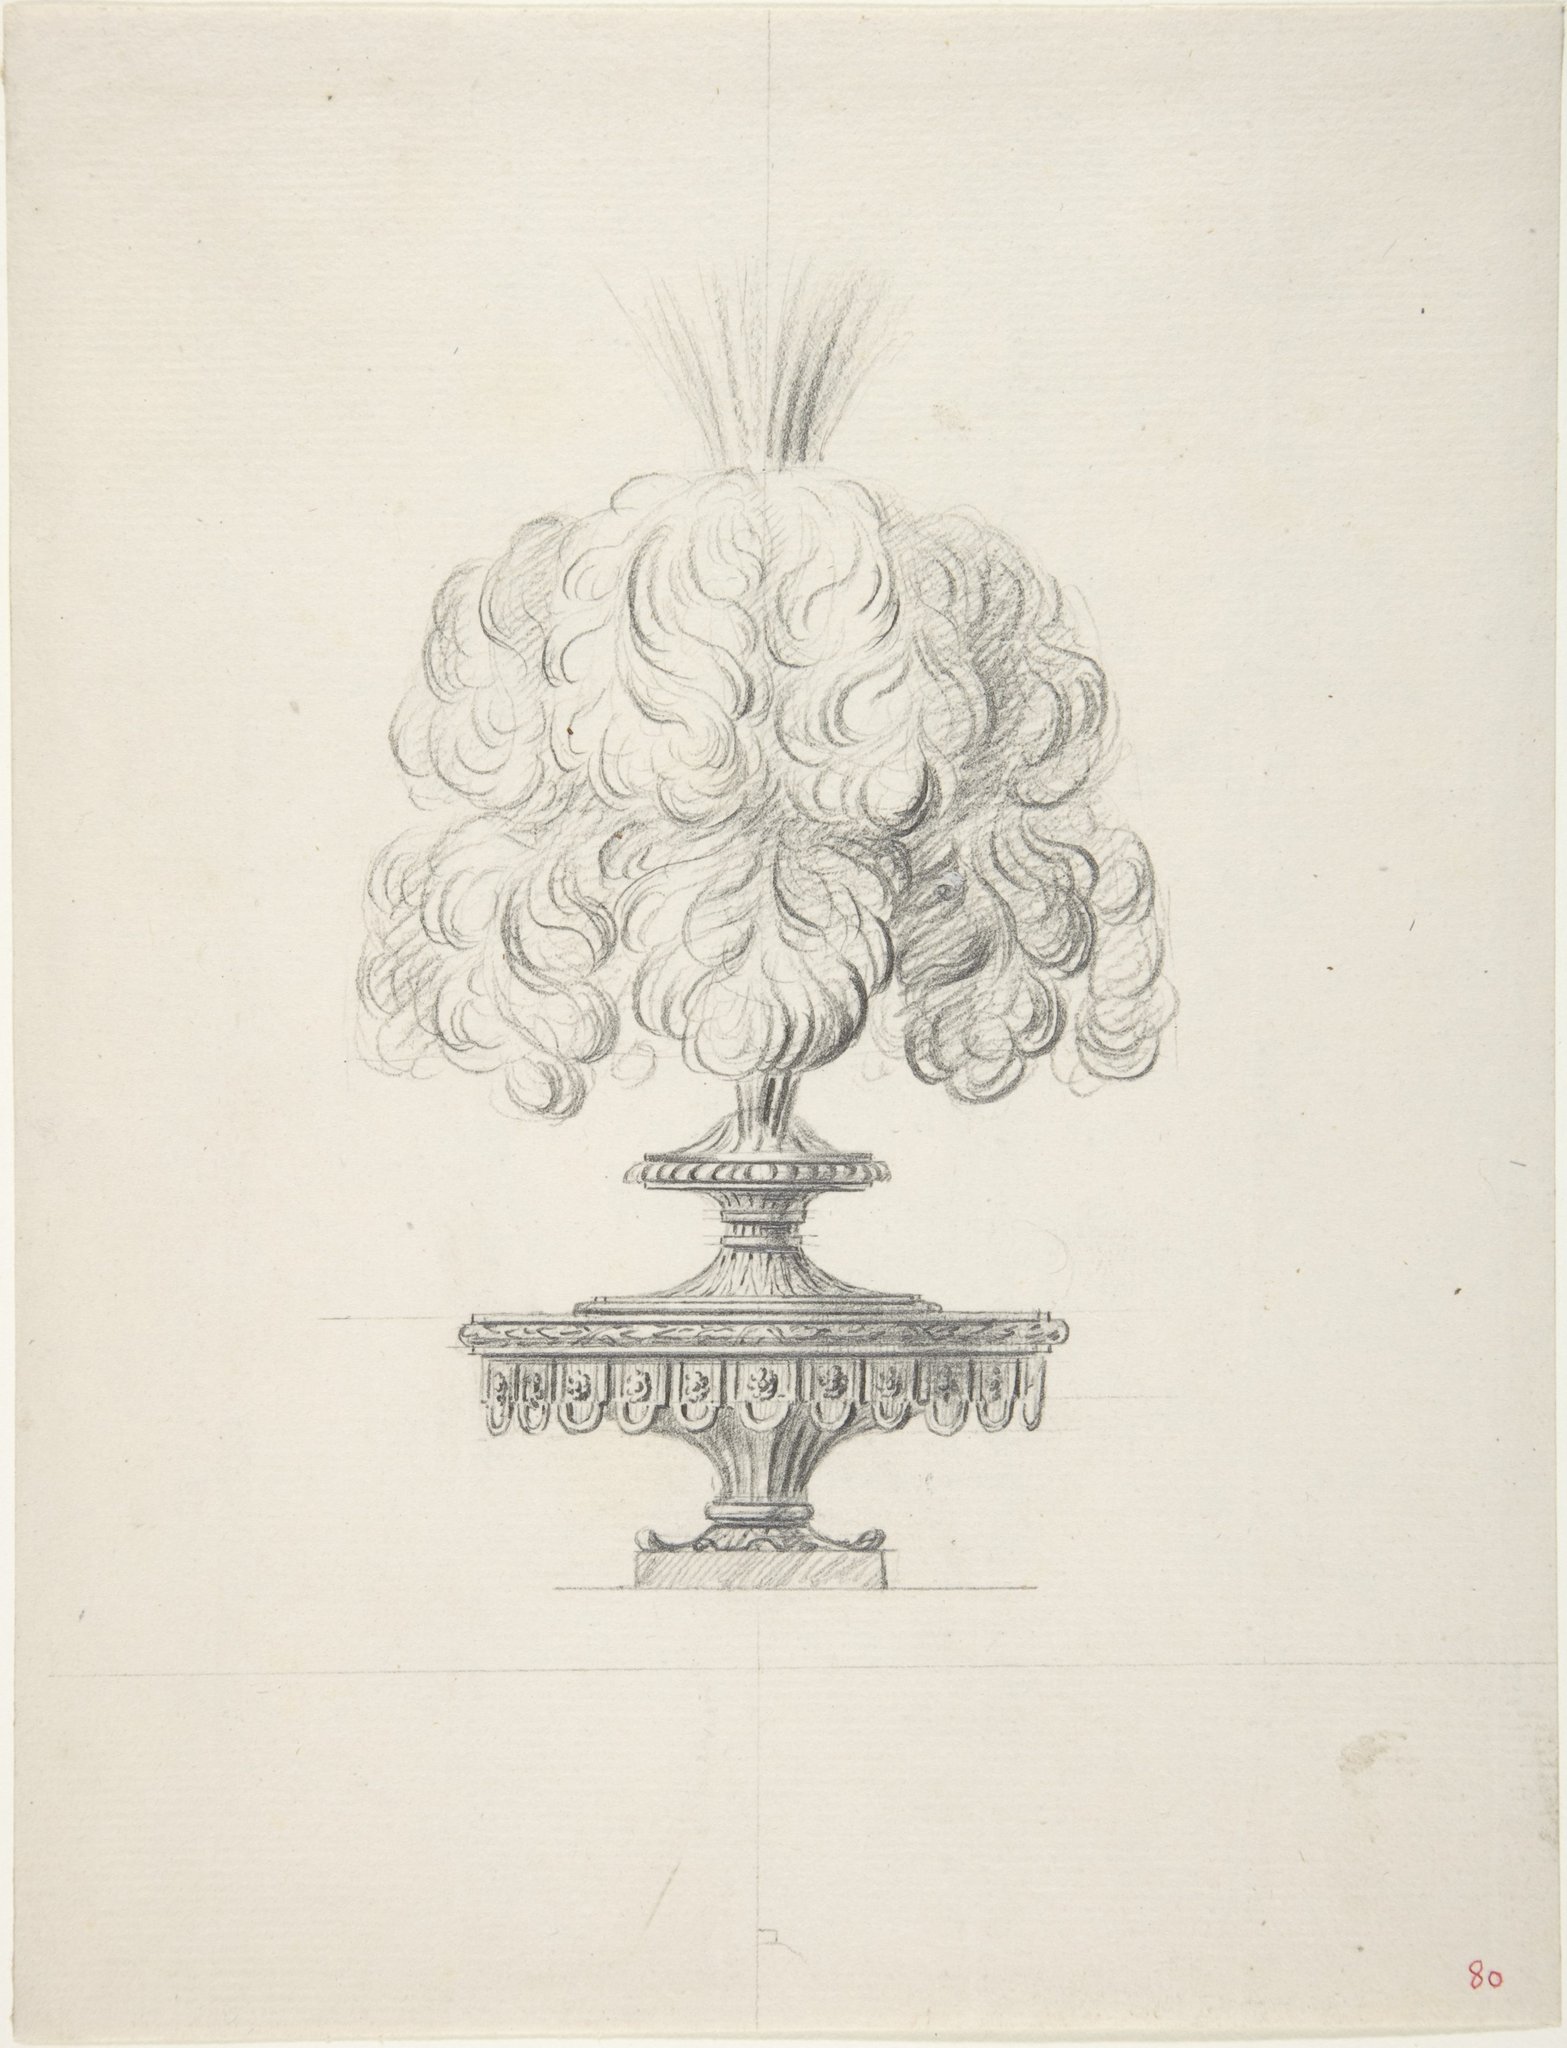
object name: drawing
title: Design for a Plumed Oil Lamp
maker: anonymous, french, 18th century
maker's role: artist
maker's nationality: french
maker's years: 1700-1800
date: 1770-1790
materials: graphite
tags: lamps